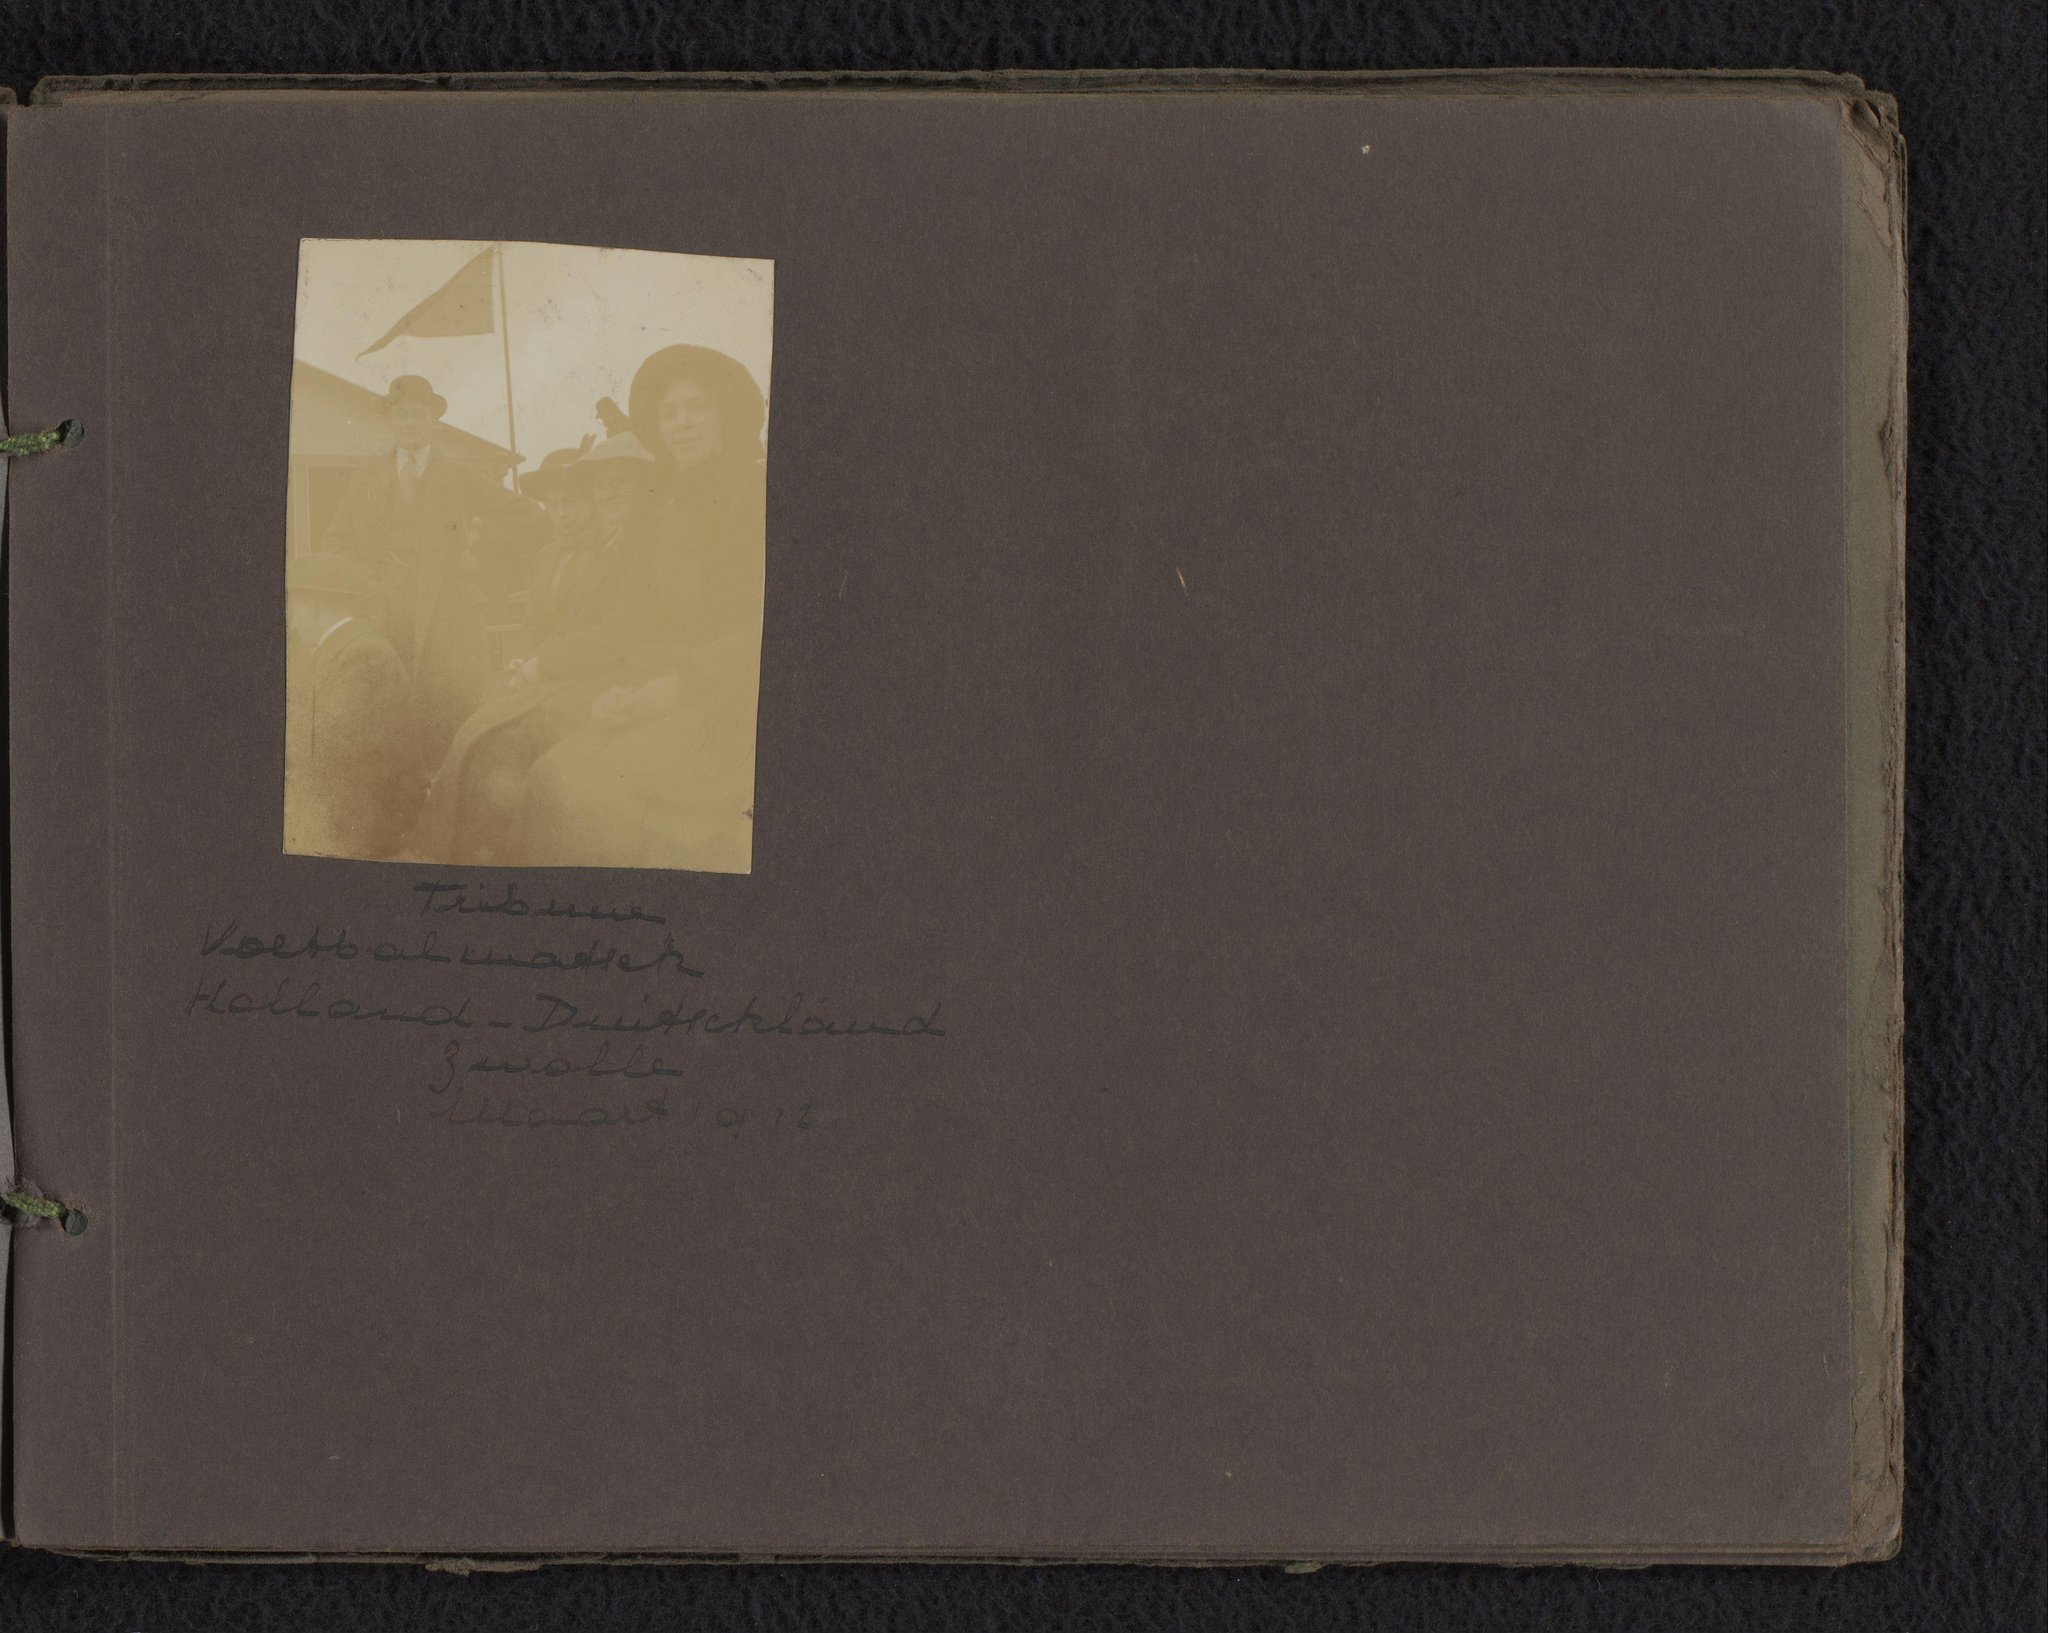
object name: photograph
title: Gezicht op de tribune tijdens de voetbalwedstrijd Nederland-Duitsland in Zwolle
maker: carolina frederika onnen (lien/loen)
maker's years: 1896-1983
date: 1912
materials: paper, cardboard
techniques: collodion silver print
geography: zwolle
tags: amsterdam, carolina frederika onnen (lien/loen), soccer, football (early names: soule, choule, cholle)